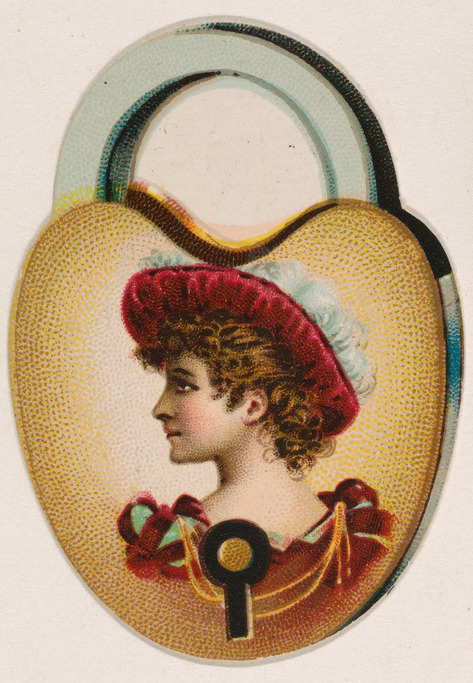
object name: print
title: Padlock, from the Novelties series (N228, Type 3) issued by Kinney Bros.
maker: kinney brothers tobacco company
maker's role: publisher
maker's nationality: american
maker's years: 1869-2011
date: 1889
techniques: color lithograph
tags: women